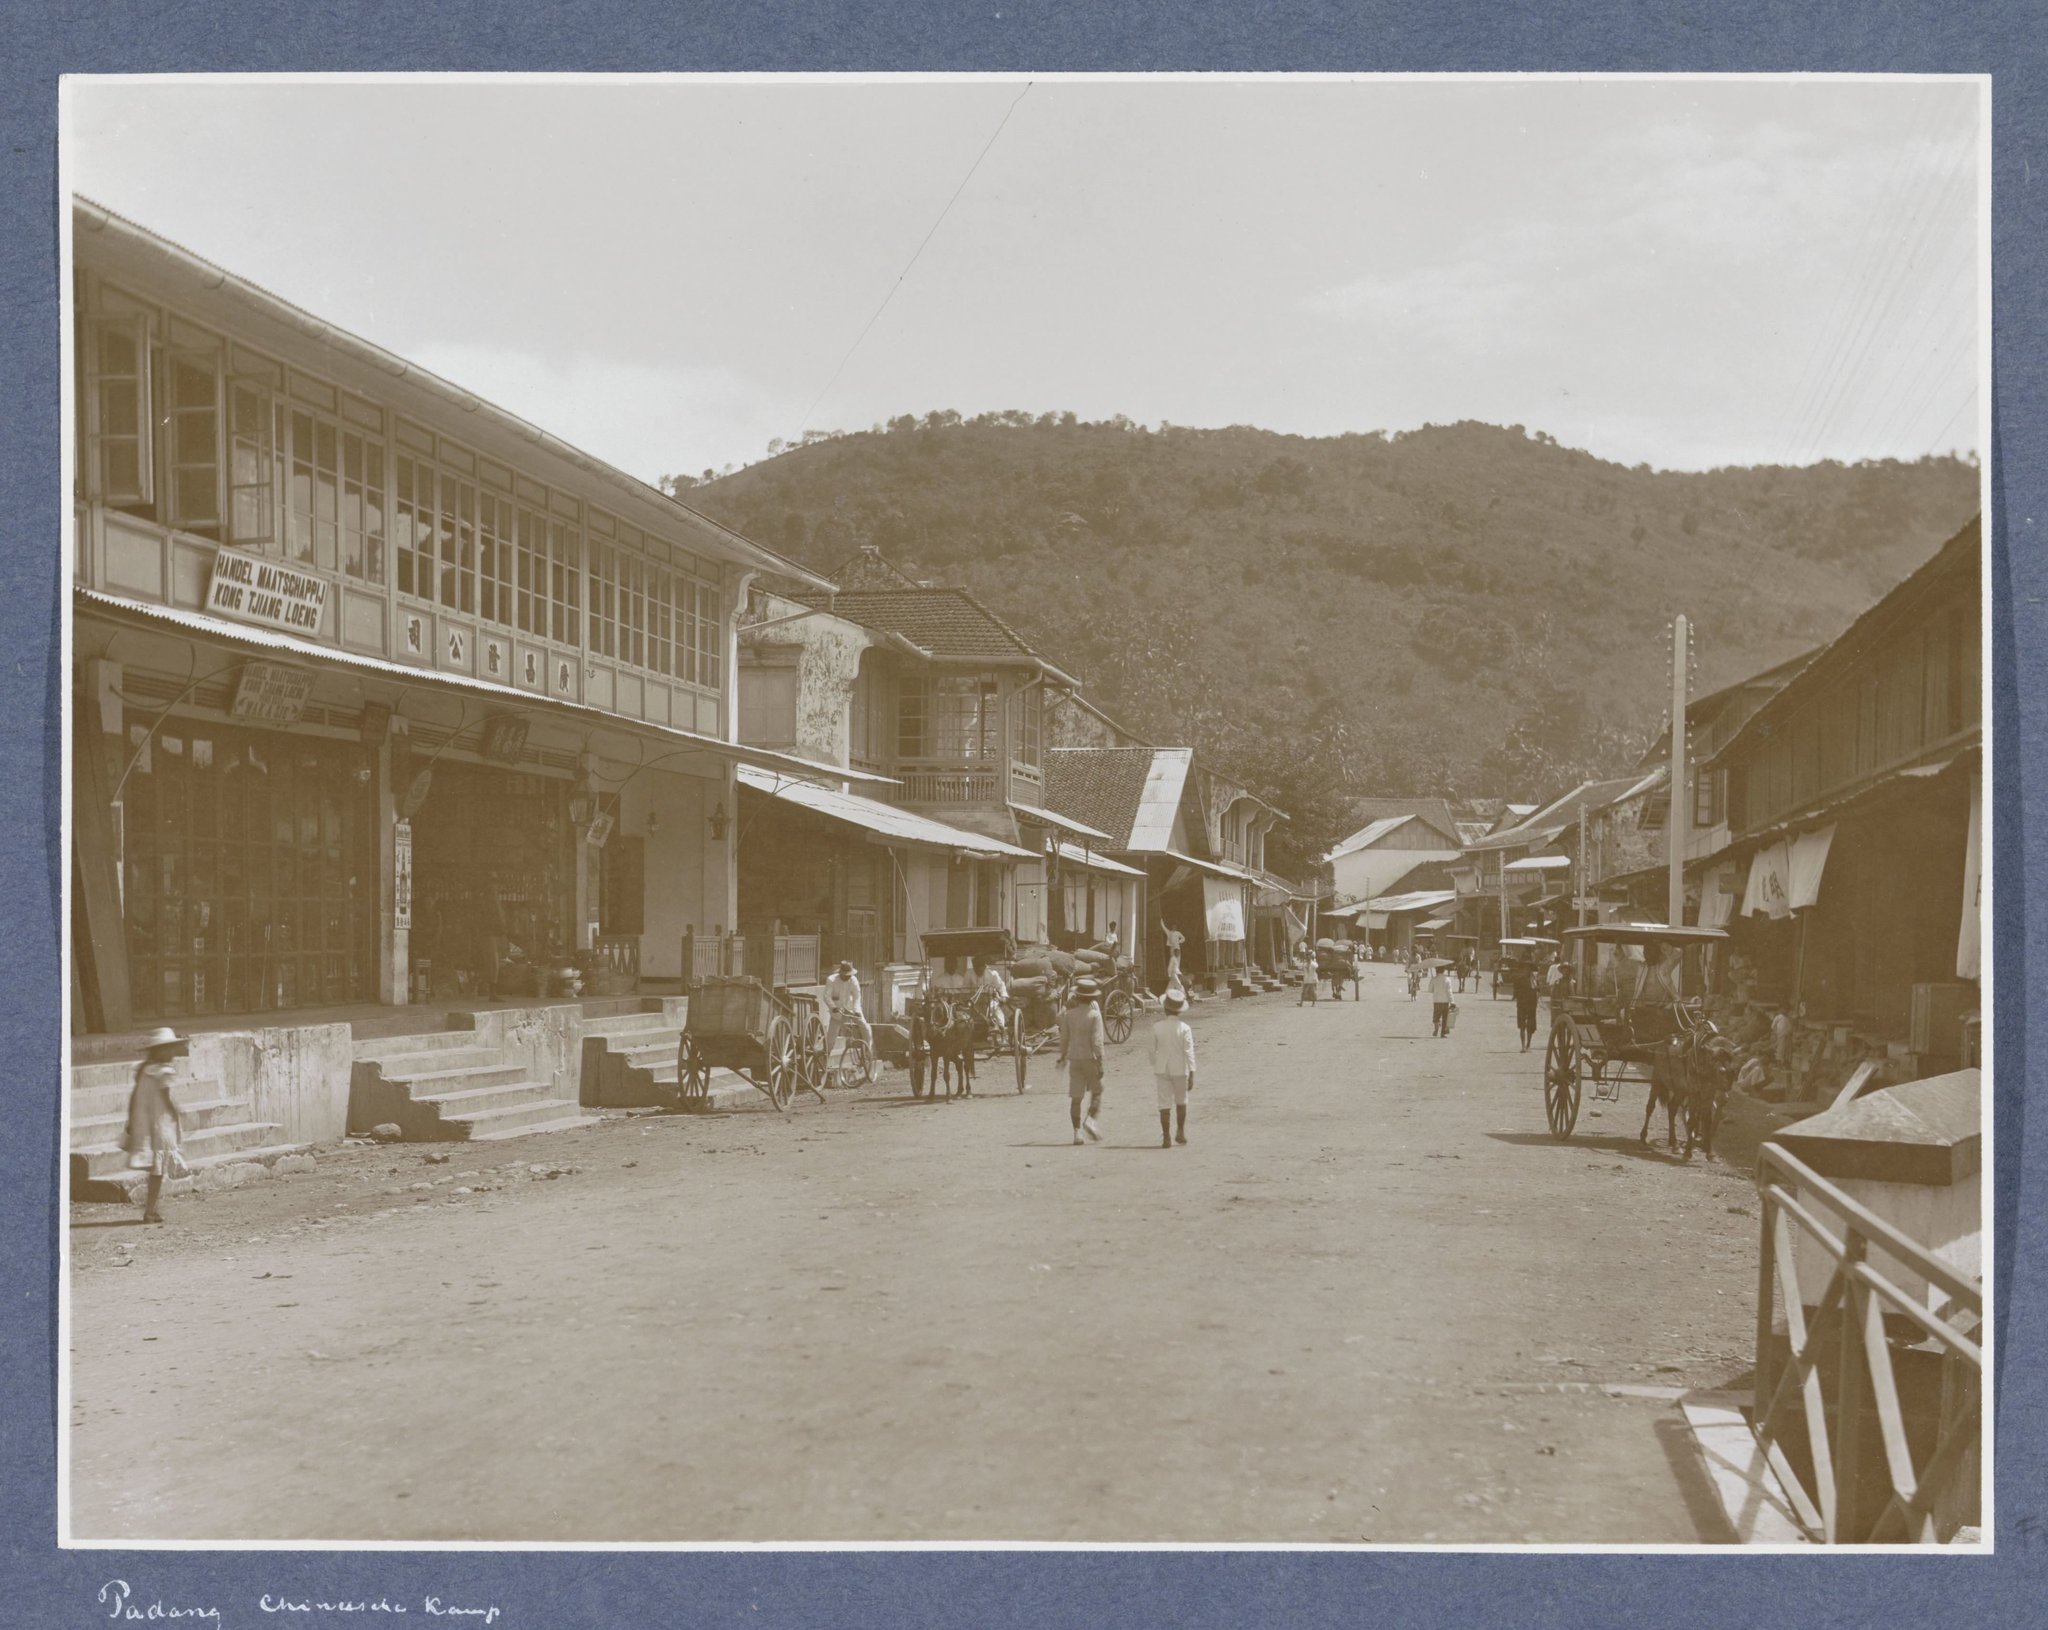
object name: album leaf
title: Straat in de Chinese Kamp in Padang met links het gebouw van 'Handel Maatschappij Kong Tjiang Loeng voor heen Ma A Sie'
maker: christiaan benjamin nieuwenhuis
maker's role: publisher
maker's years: 1863-1922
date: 1900-1920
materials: paper, photographic support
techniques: gelatin silver print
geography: padang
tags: shop, store, street (+ city(-scape) with figures, staffage)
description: Onderdeel van reisalbum met foto's van bedrijvigheid en bezienswaardigheden op Sumatra en Java en van de reis naar en van Nederlands-Indië.